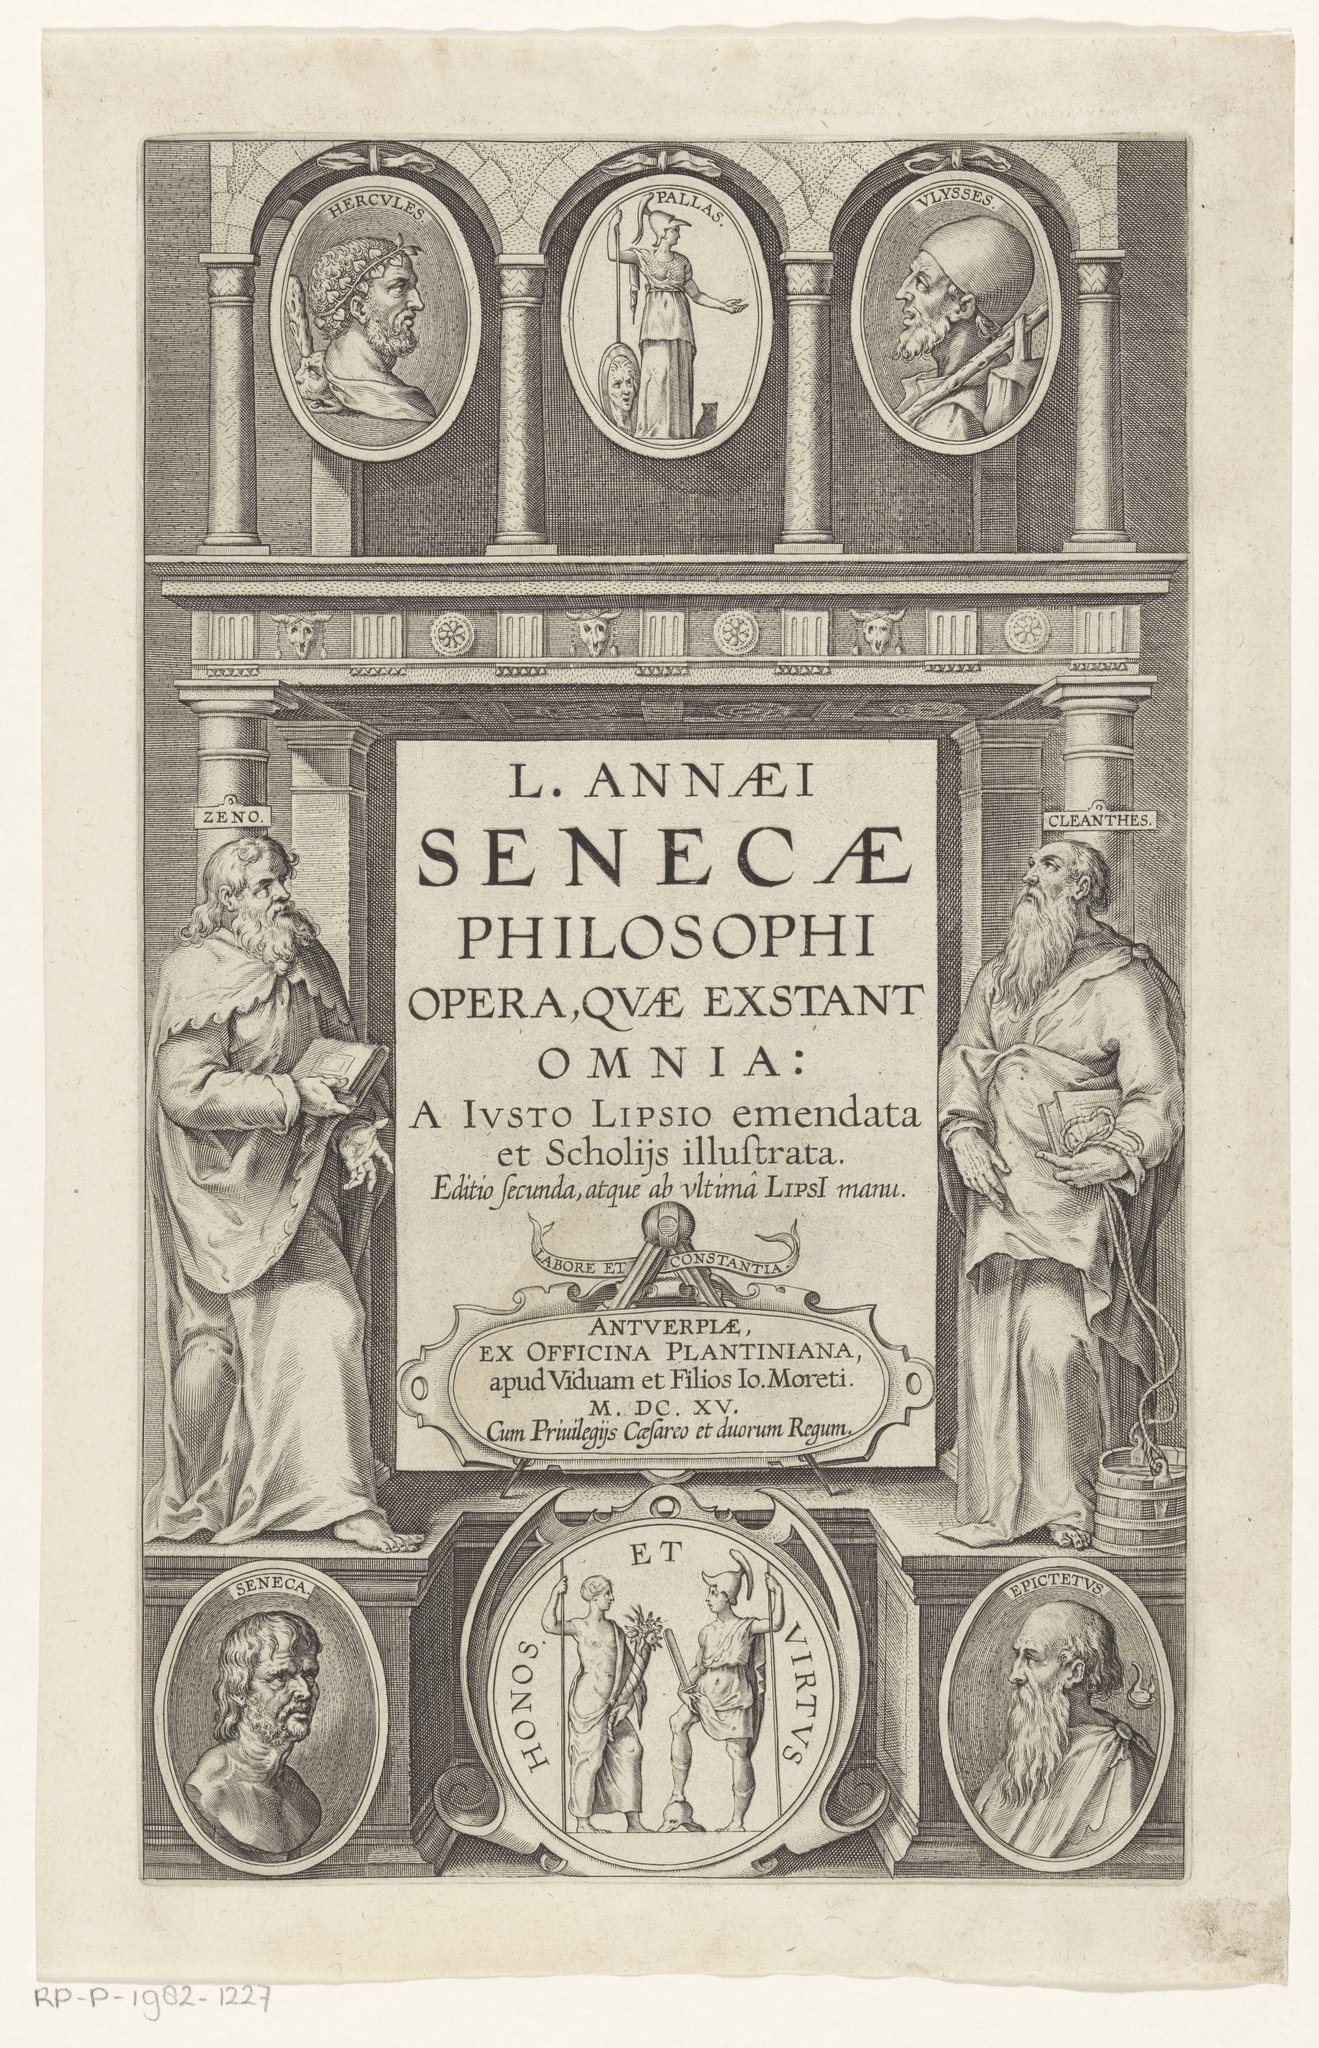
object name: titelblad, titelpagina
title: Filosofen Zeno en Cleanthes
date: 1615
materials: paper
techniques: engraving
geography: antwerp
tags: male persons from classical history (zeno), male persons from classical history (cleanthes)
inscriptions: collector's mark: Lugt 2760, collector's mark: Lugt 2228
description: Centraal in een rechthoekig kader de titel van het boekwerk. Aan weerszijden van het kader de klassieke filosofen Zeno en Cleanthes. Bovenaan de portretten van Hercules, Minerva en Odysseus in ovale lijsten. Onderaan de prent de portretten van Seneca en Epictetus.